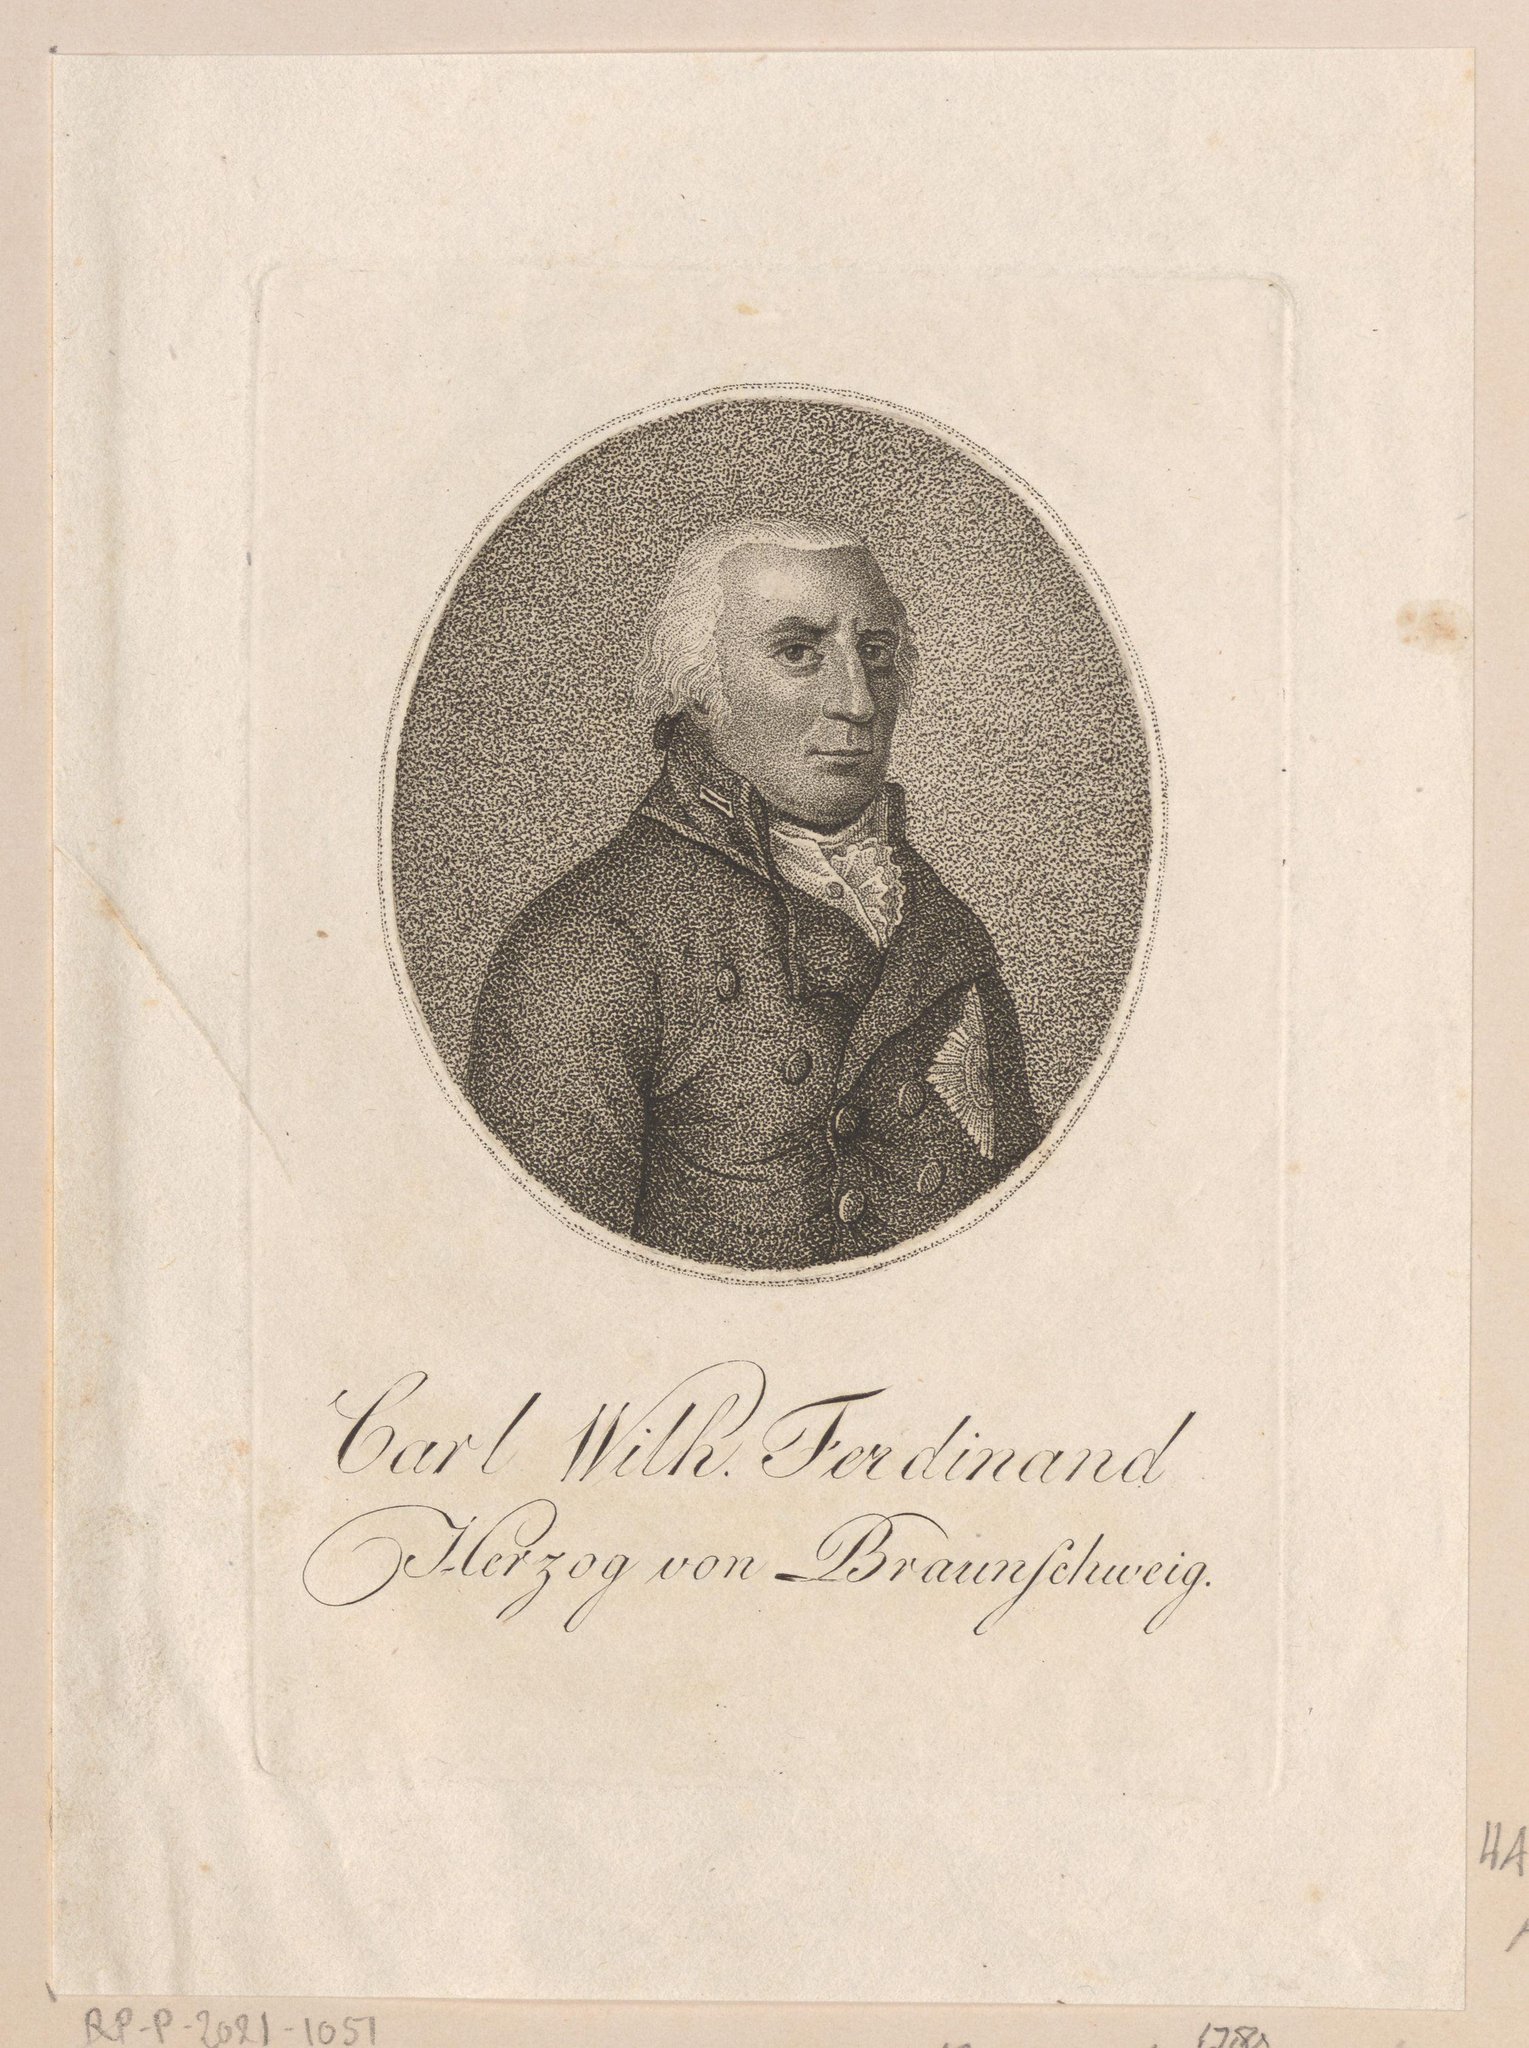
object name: print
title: Portret van Karel Willem Ferdinand hertog van Brunswijk-Wolfenbüttel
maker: Anonymous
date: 1811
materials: paper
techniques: engraving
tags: karel willem ferdinand hertog van brunswijk-wolfenbüttel, historical persons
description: Prent mogelijk uit: Pragmatische Geschichte der Europäischen Staaten (...). Gotha: Carl Steudel, 1811.